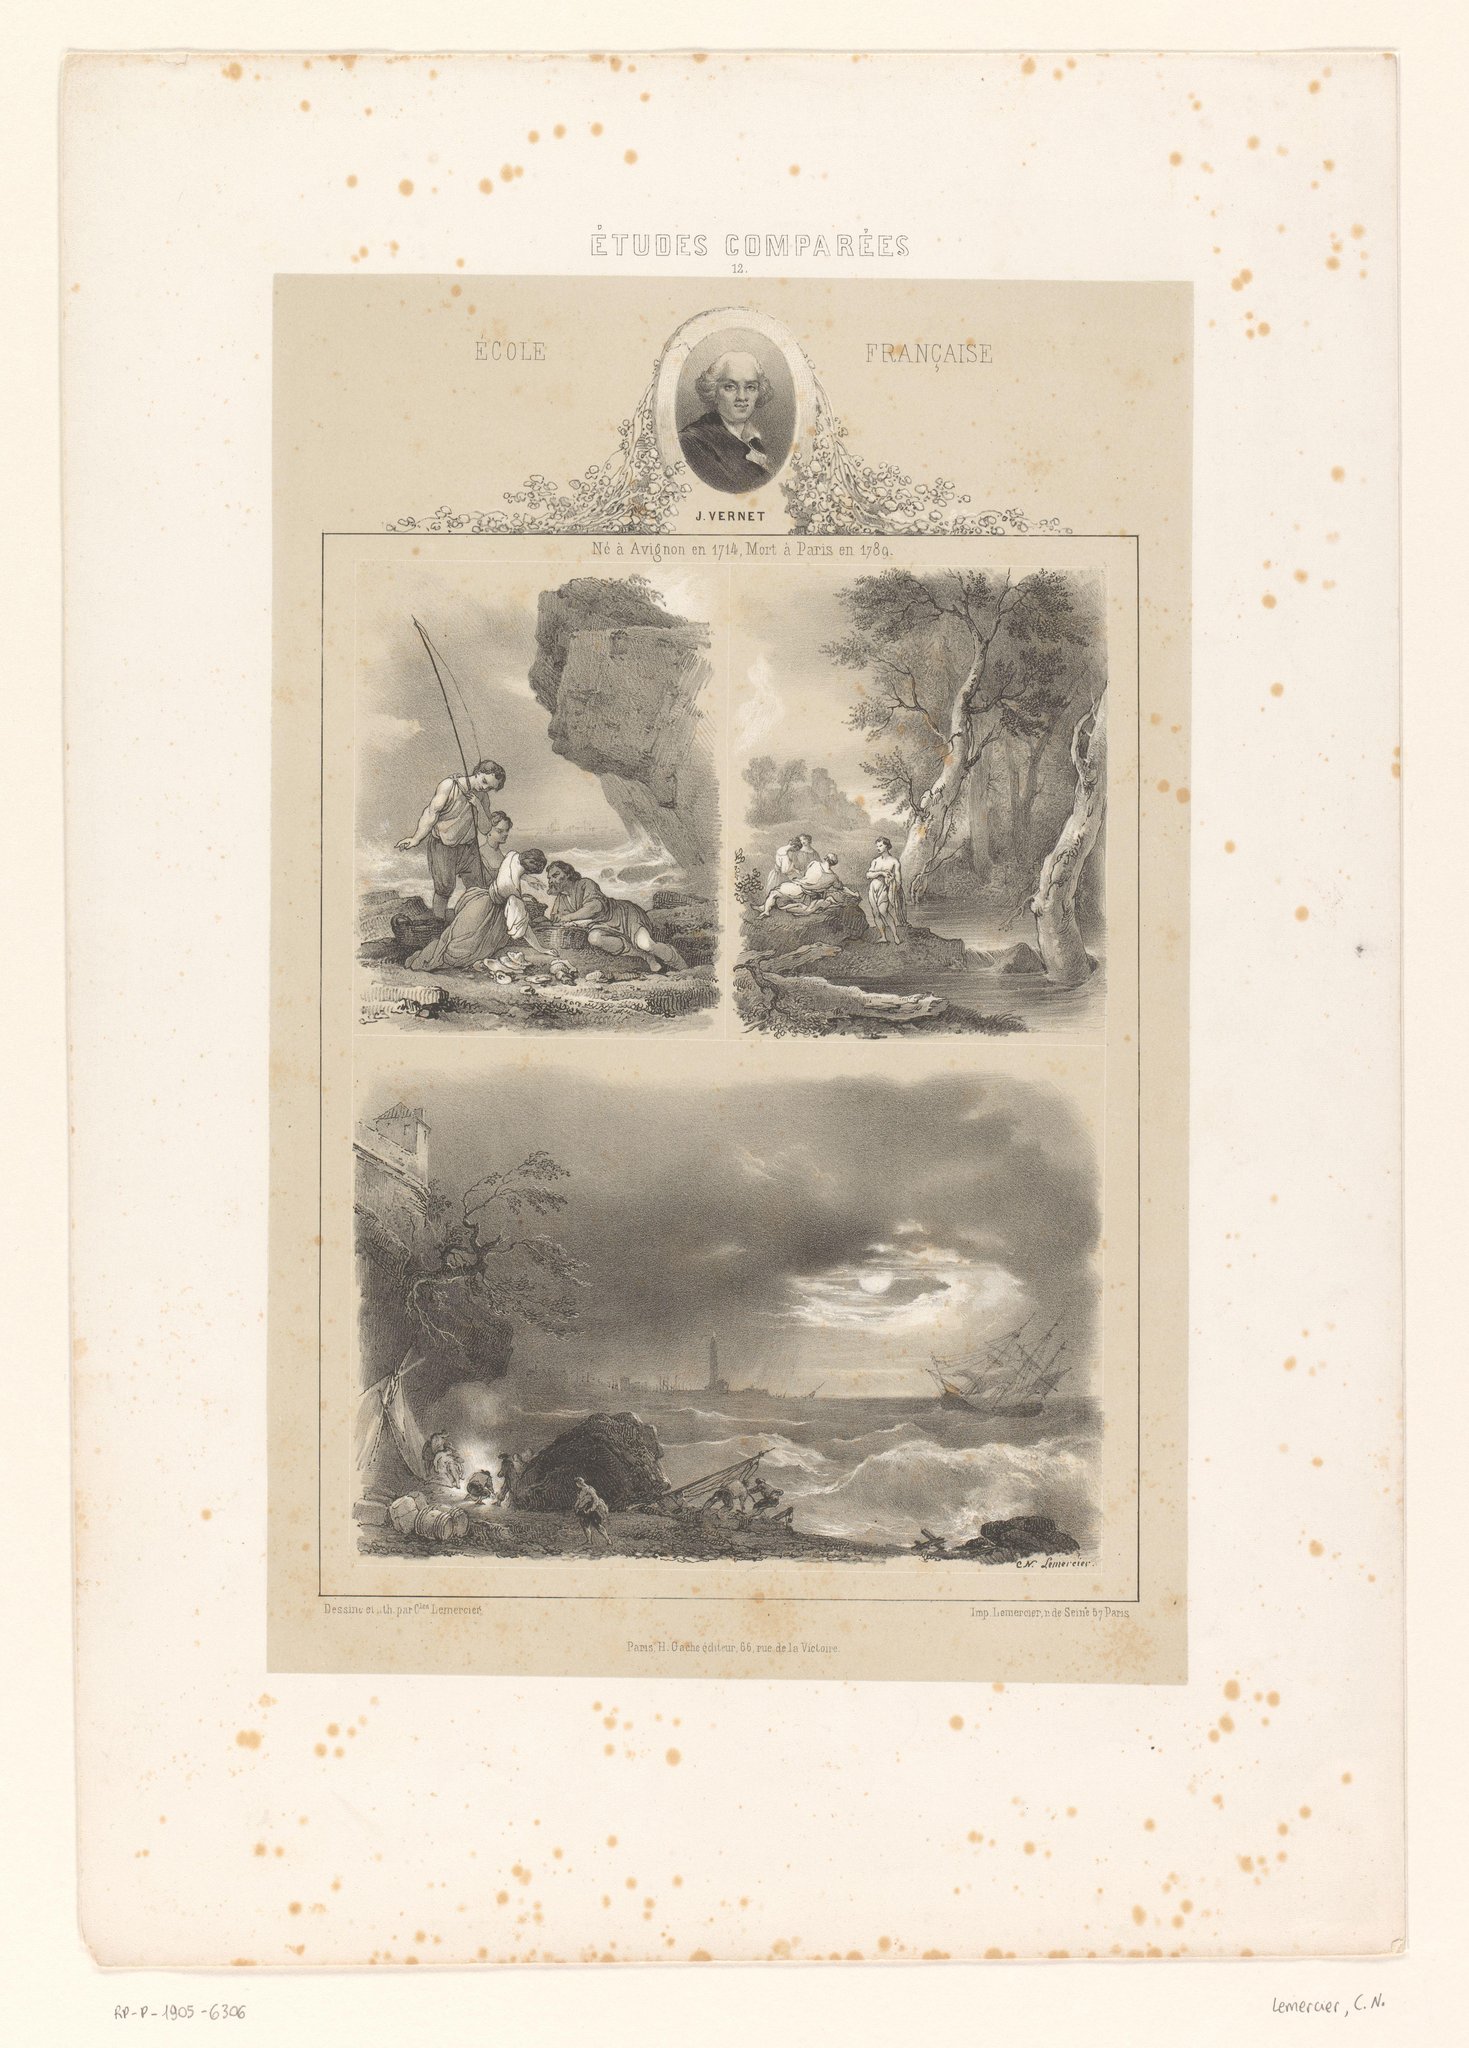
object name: print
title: École Française. J. Vernet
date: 1850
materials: paper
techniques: tone lithography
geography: paris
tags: paris, painter, print maker, draughtsman, claude joseph vernet, historical persons, rocky coast, portrait, self-portrait of painter, storm at sea, pastorals, arcadian scenes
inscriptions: collector's mark: Lugt 2228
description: Midden boven genummerd: 12. Met midden boven een portret van Vernet.